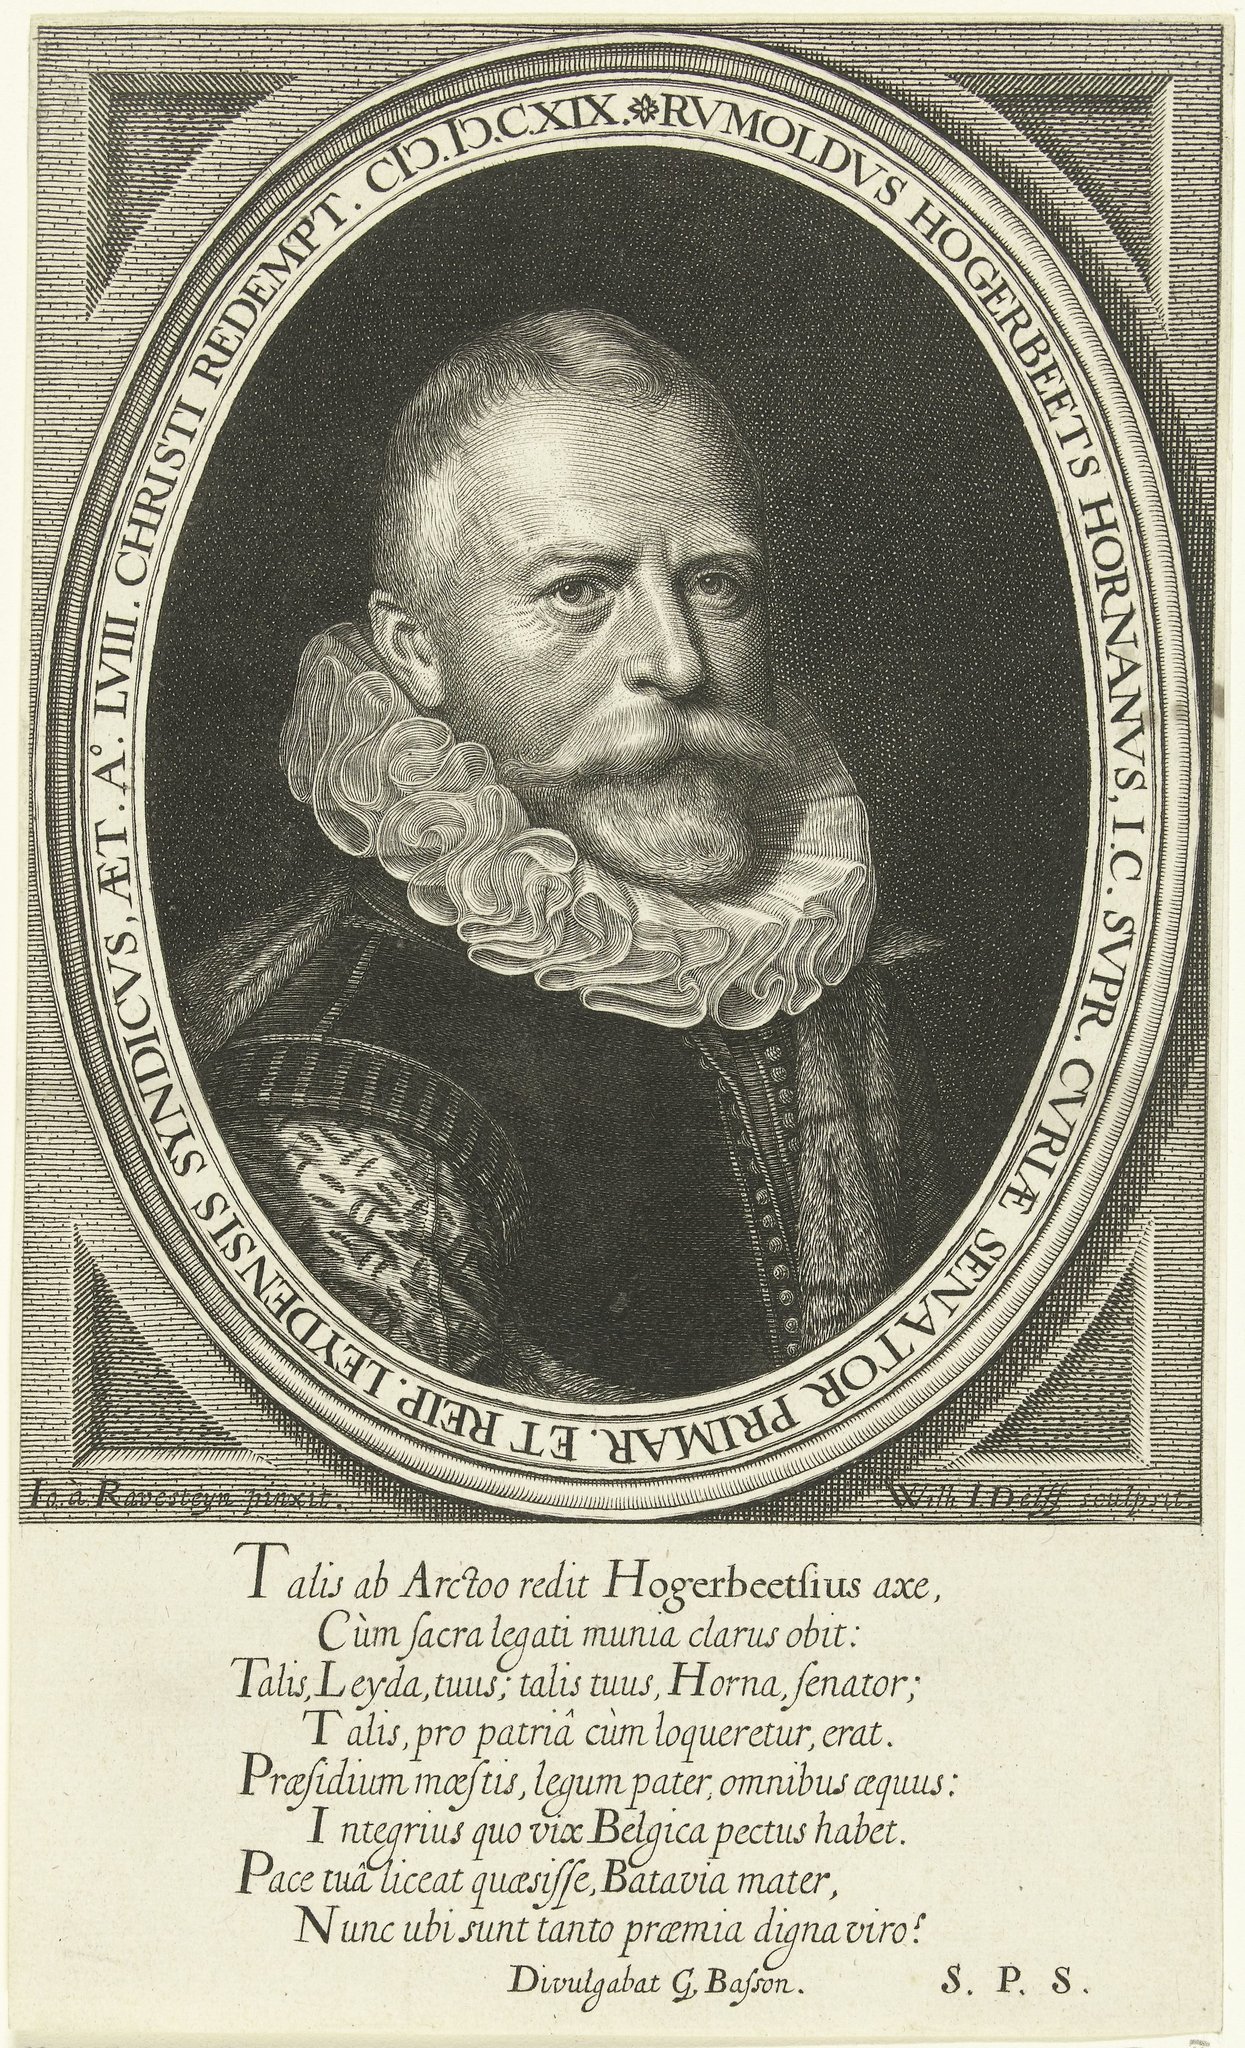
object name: print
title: Portret van pensionaris Rombout Hogerbeets op 58-jarige leeftijd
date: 1619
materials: paper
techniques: engraving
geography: delft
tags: hoorn (north holland), leiden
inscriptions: collector's mark: Lugt 2228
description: Rombout Hogerbeets werd in 1619 veroordeeld tot levenslange gevangenschap op Slot Loevestein, samen met Hugo de Groot, vanwege zijn contacten met Johan van Oldebarnevelt. Deze prent werd volgens een plakkaat op 13 november 1619, in het jaar dat Delff hem vervaardigde, verboden voor de verkoop, zie notitie op los blad bij andere staat van dit portret. Op verso van deze prent moeilijk leesbare aantekening over boete van 200 gulden welke de drukker moest betalen omdat hij deze verordening negeerde.